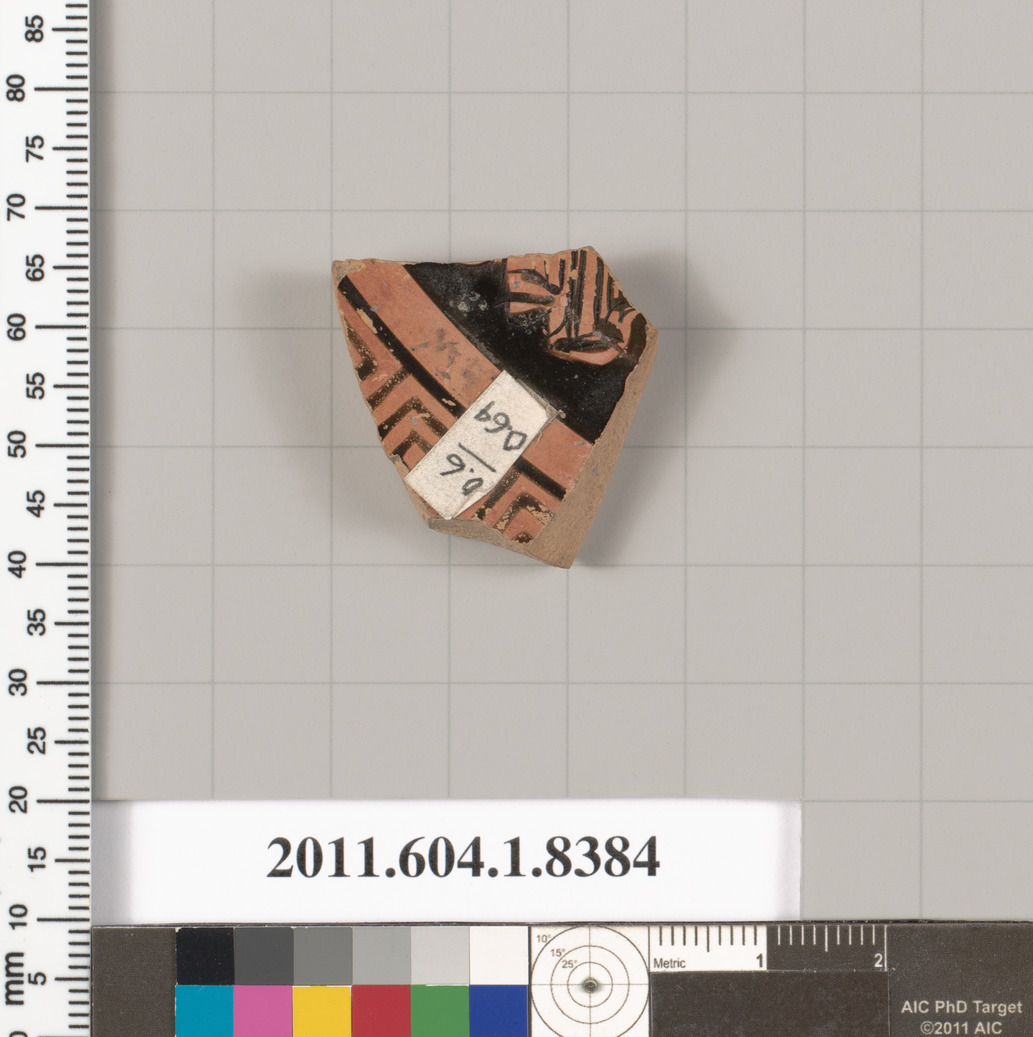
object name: kylix fragment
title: Terracotta fragment of a kylix (drinking cup)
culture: greek, attic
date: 434-368 BCE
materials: terracotta